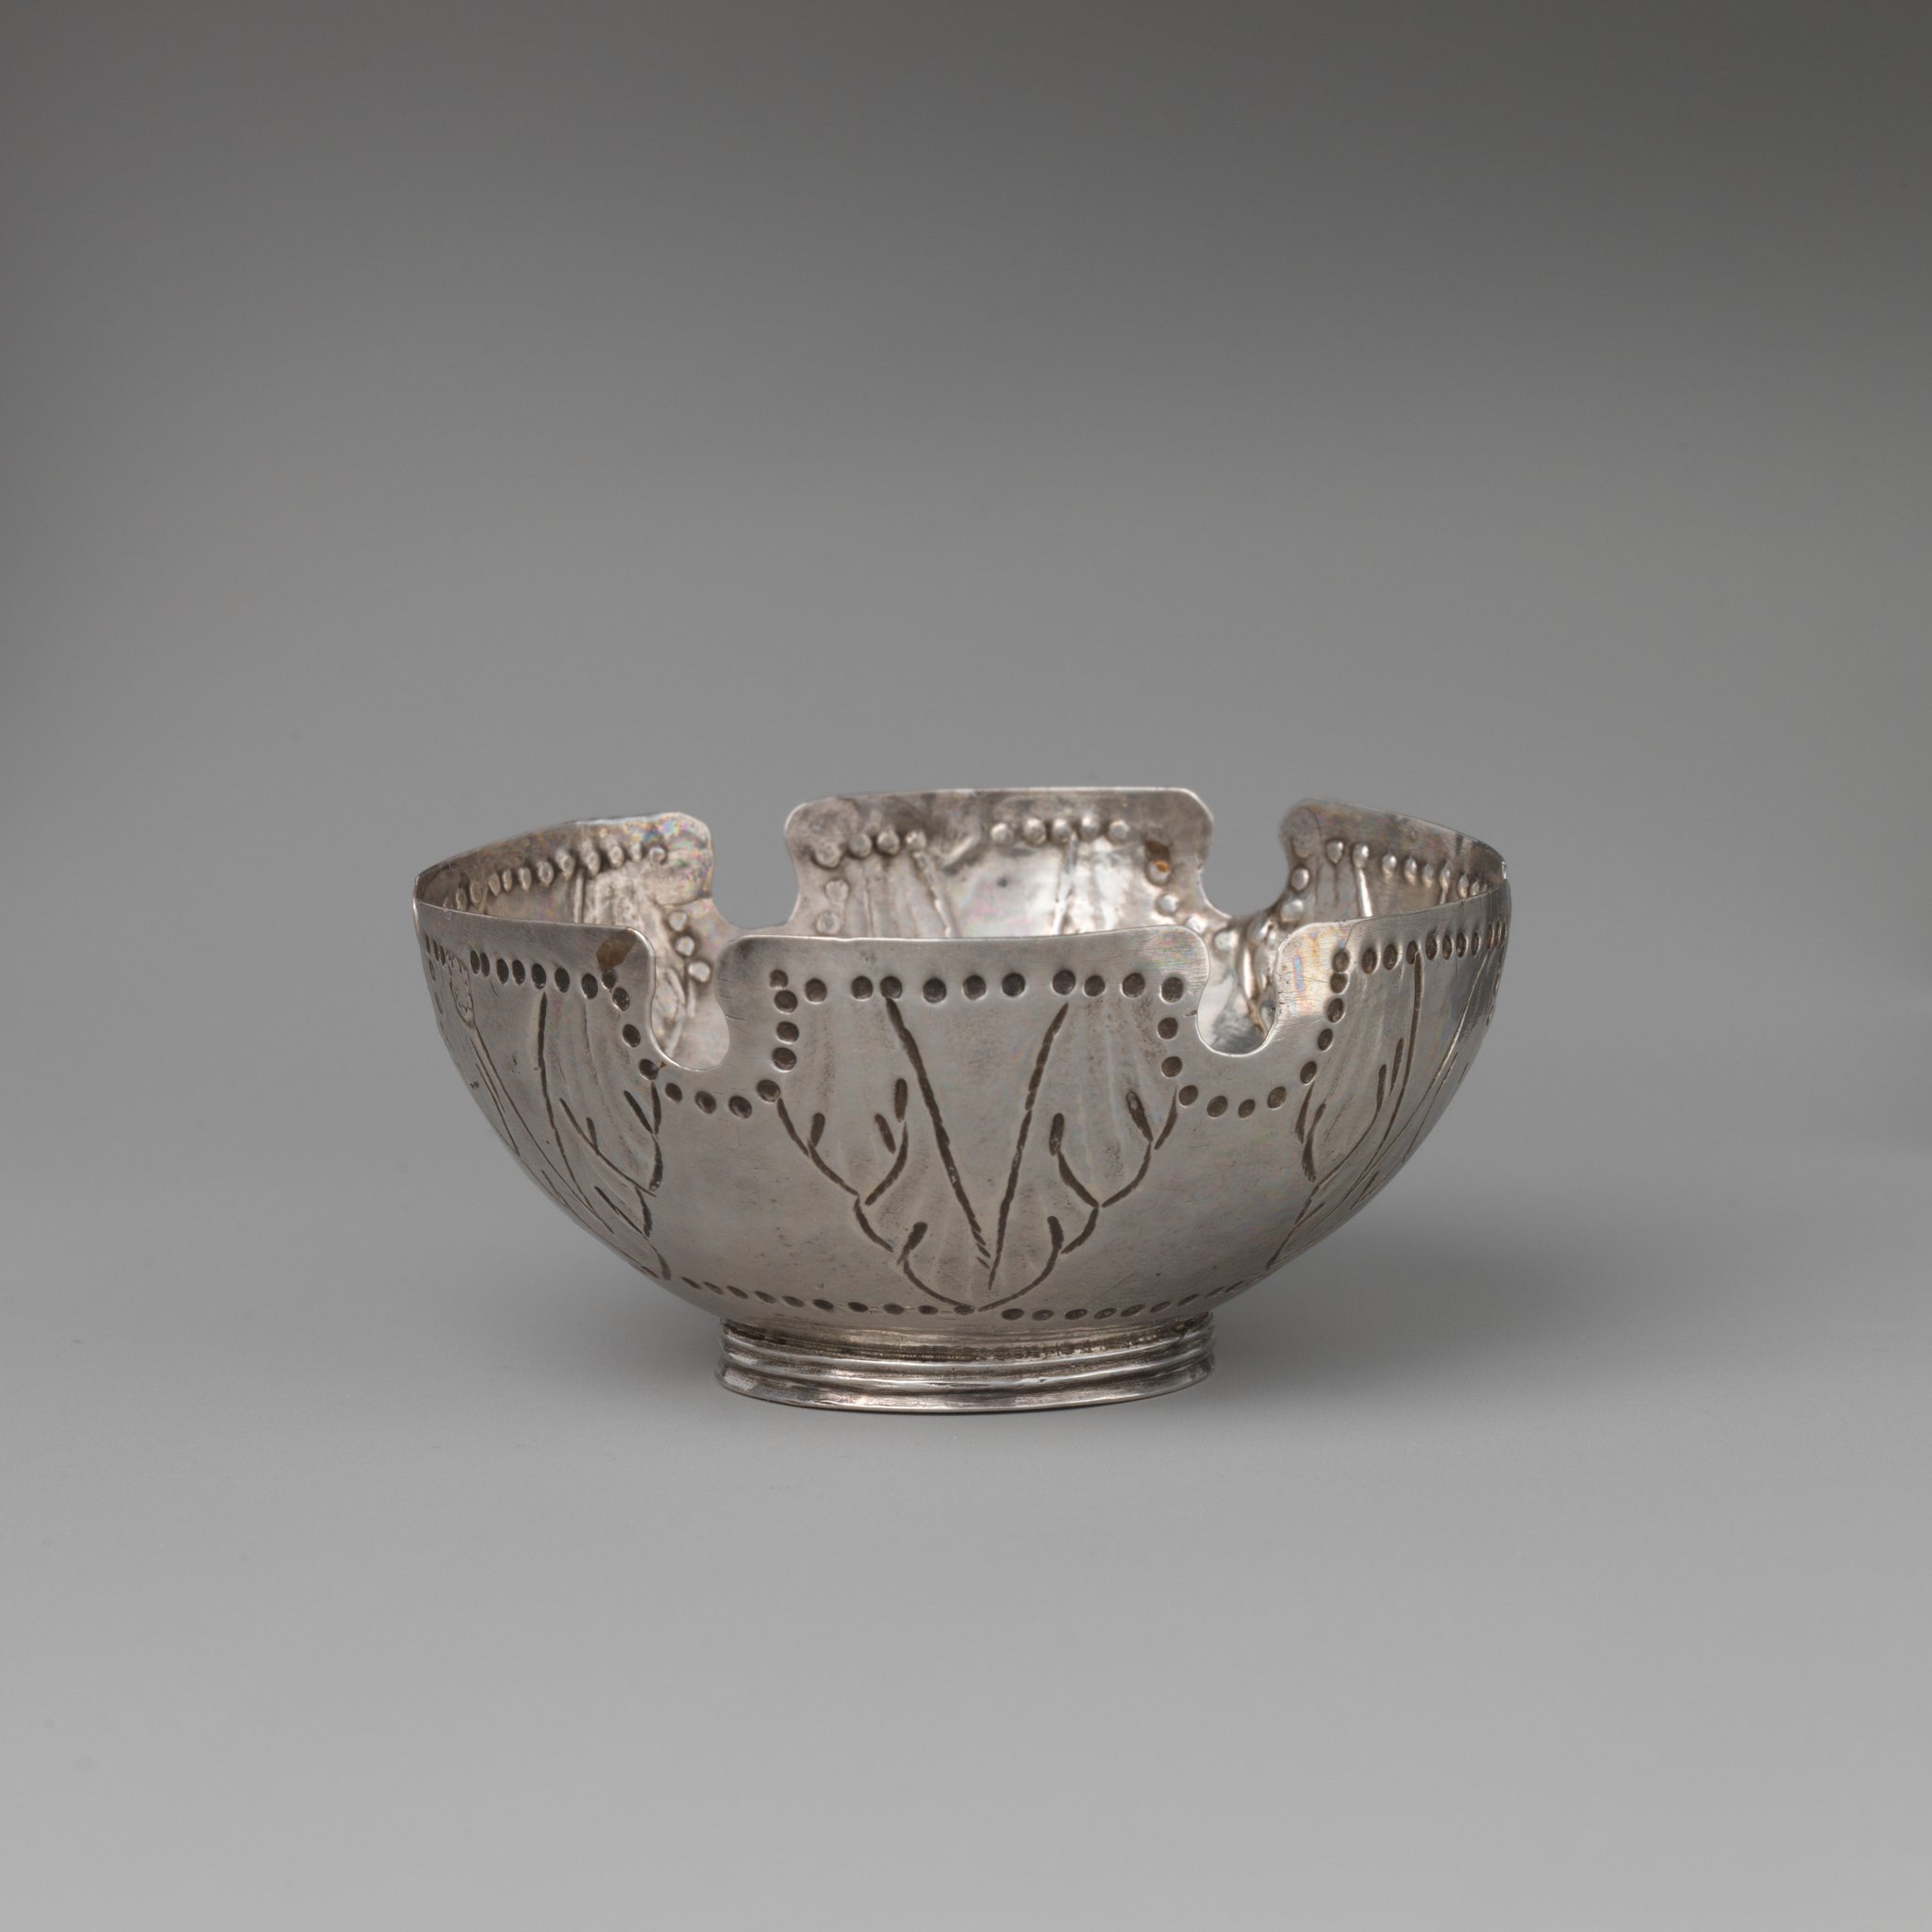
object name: monteith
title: Miniature monteith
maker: george manjoy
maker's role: maker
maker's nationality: british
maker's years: 1685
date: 1690-1691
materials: silver